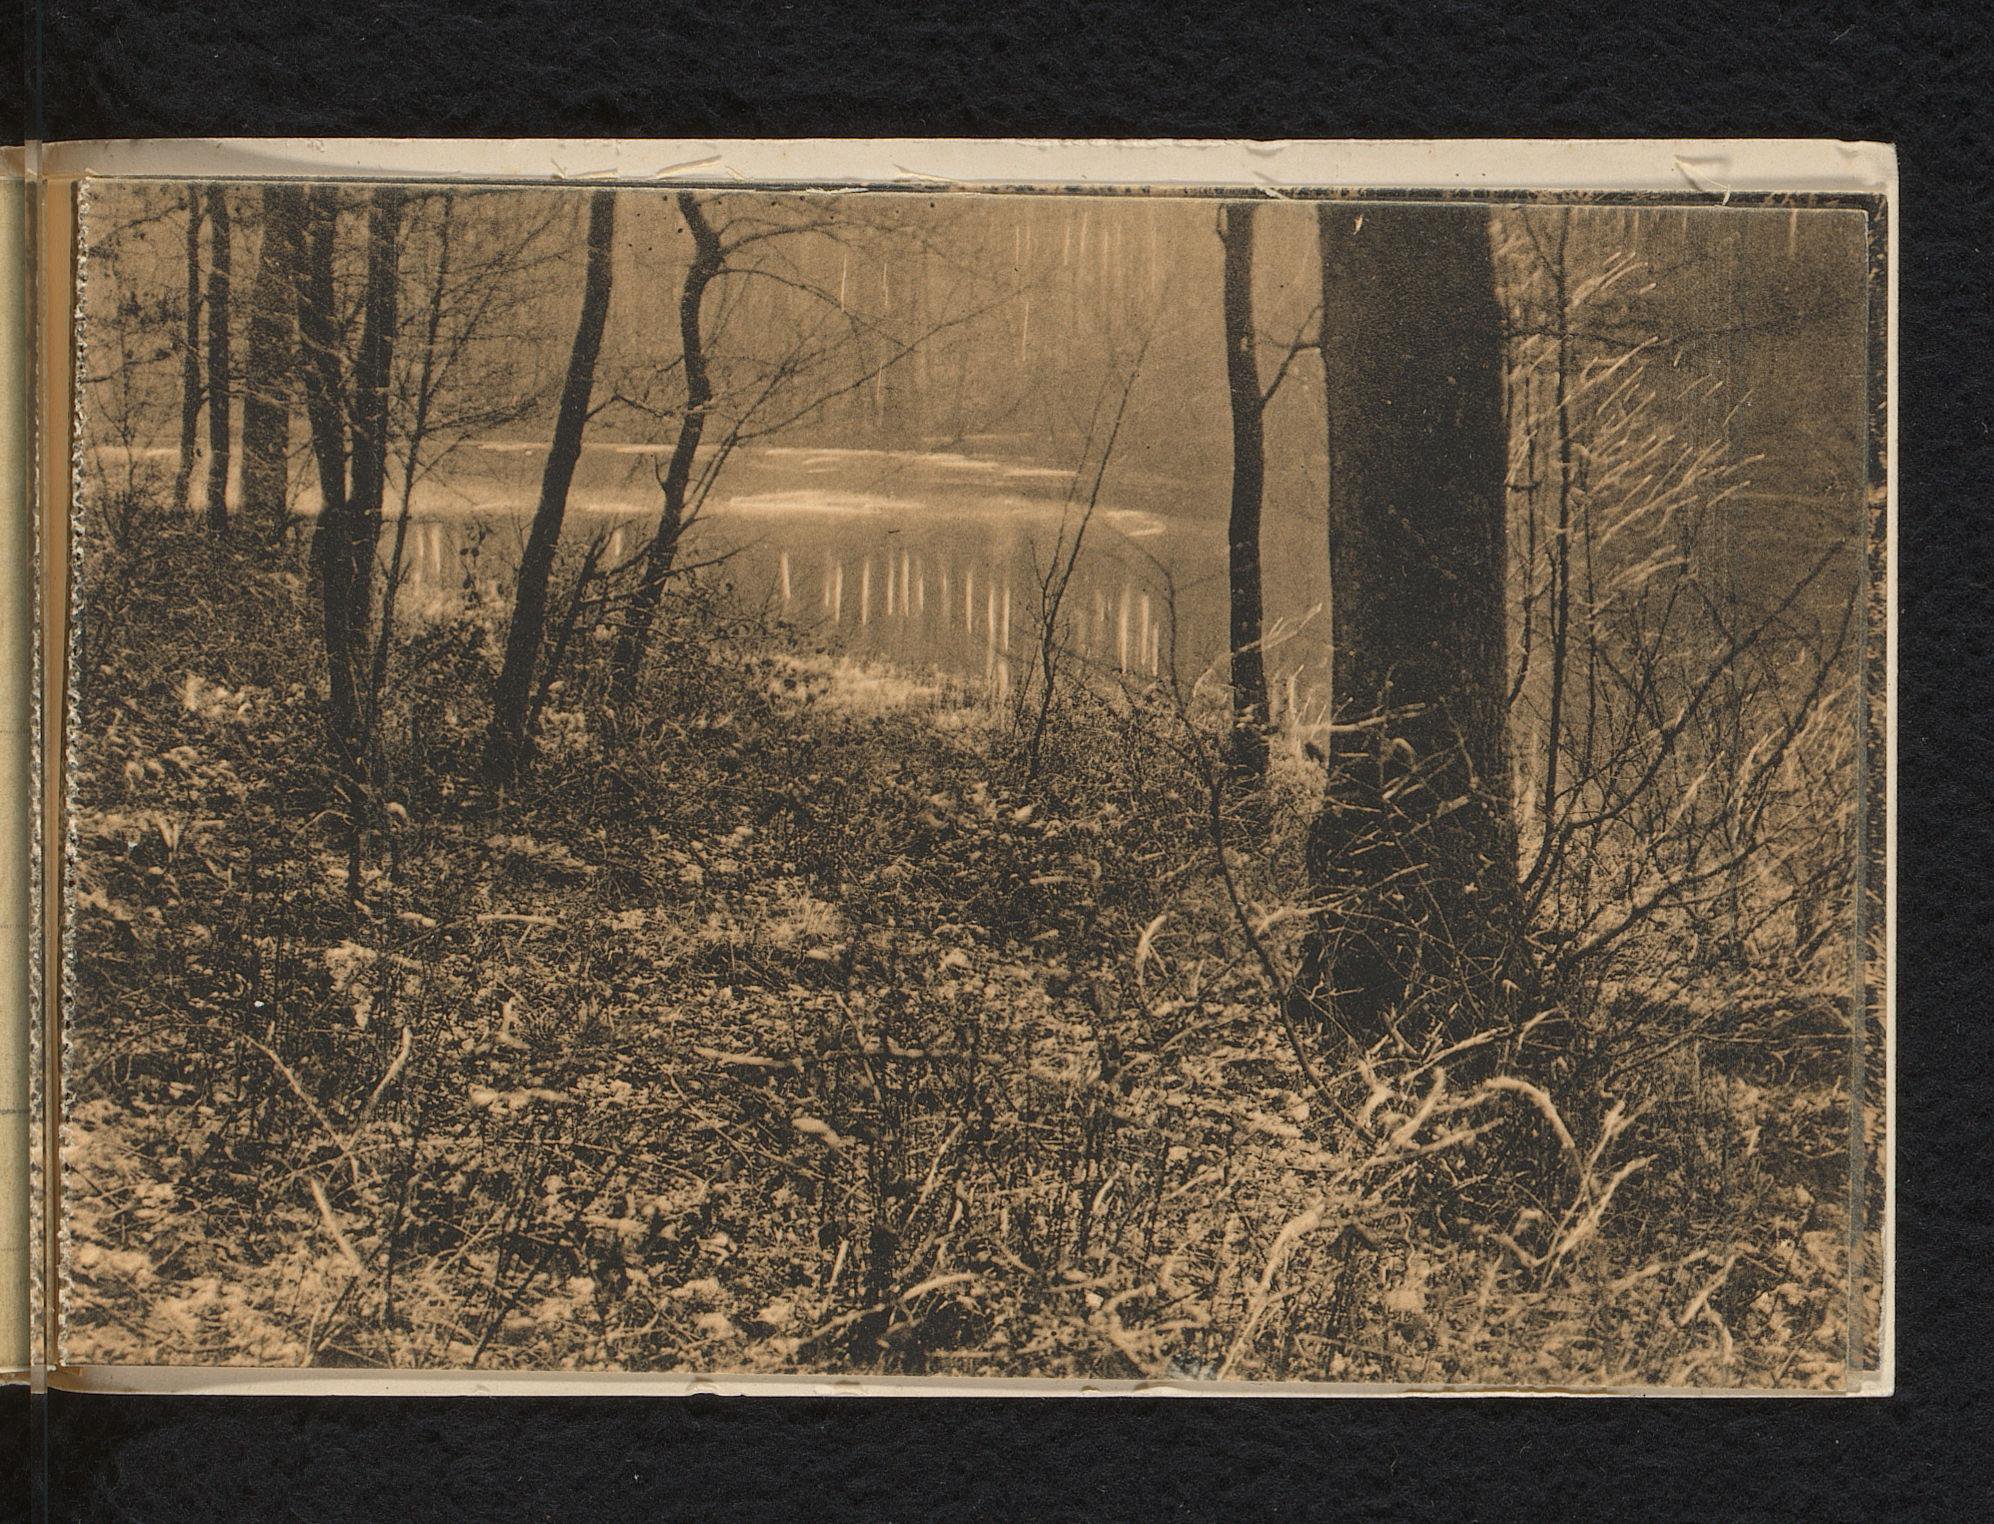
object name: photomechanical print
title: Etang des Enfants noyés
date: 1909-1914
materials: cardboard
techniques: photograph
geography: bosvoorde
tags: forest, wood, pond, pool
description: Prentbriefkaart maakt deel uit van een album.